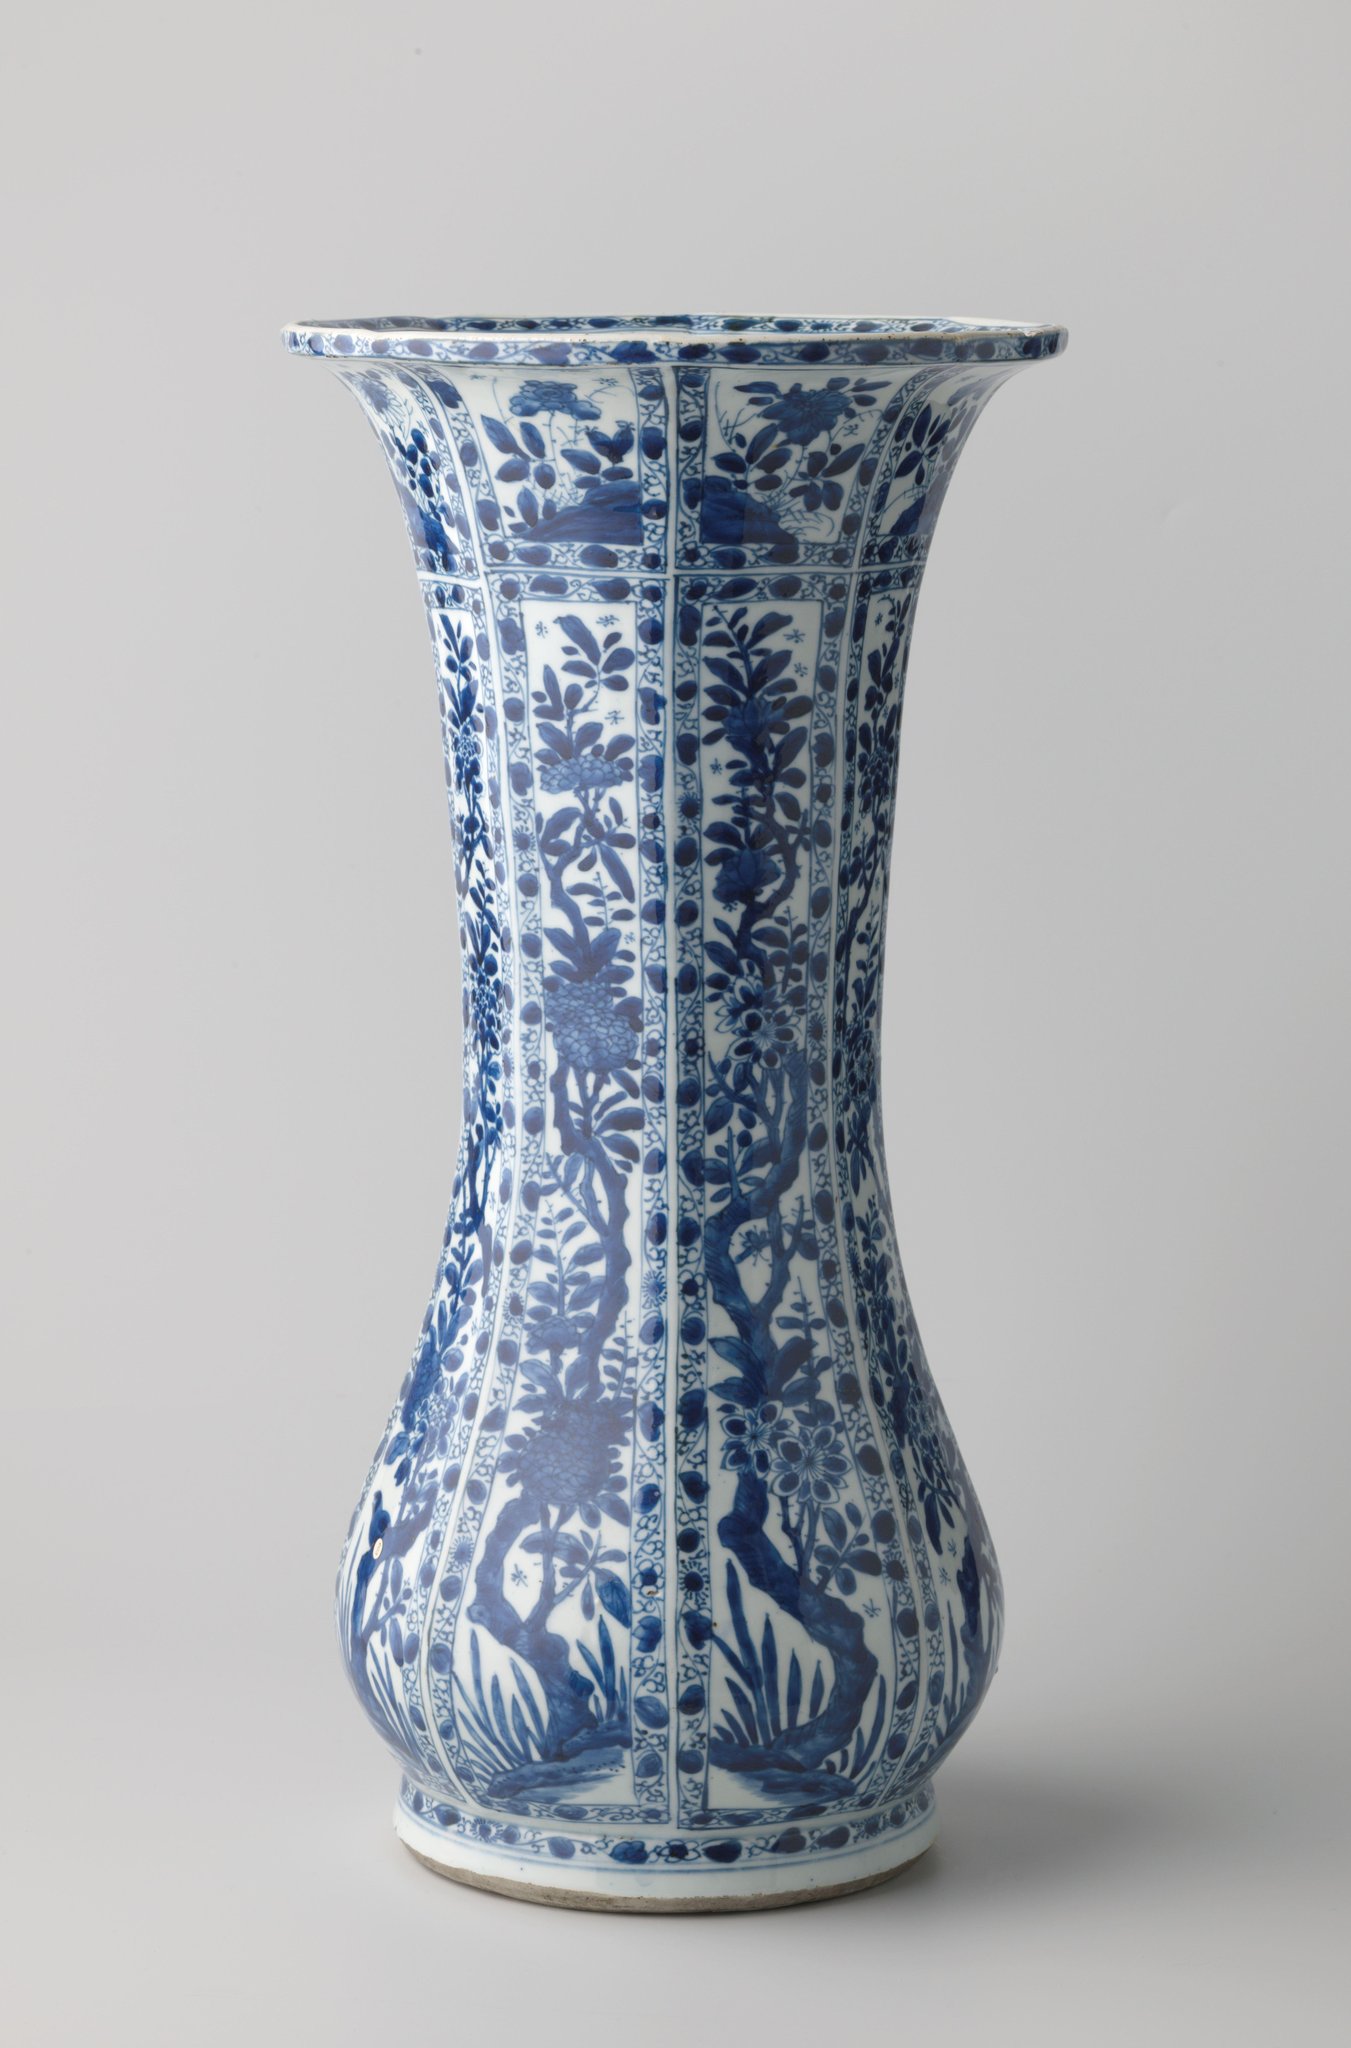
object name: vase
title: Octagonal, pear-shaped beakervase with narrow panels with flowering plants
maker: Anonymous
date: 1680-1720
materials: cobalt, glaze, paint, porcelain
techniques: firing, forming, turning, vitrification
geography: china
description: Achthoekige, peervormige bekervaas van porselein, met trompetvormige hals. Beschilderd in onderglazuur blauw. De wand is verdeeld in acht langwerpige vakken met bloeiende planten; om de vakken een band met bladranken. Onder de rand een band met vierkante vakken met bloeiende planten op rotsen. Rond de voet, binnen- en buitenrand een band met bladranken. Blauw-wit.